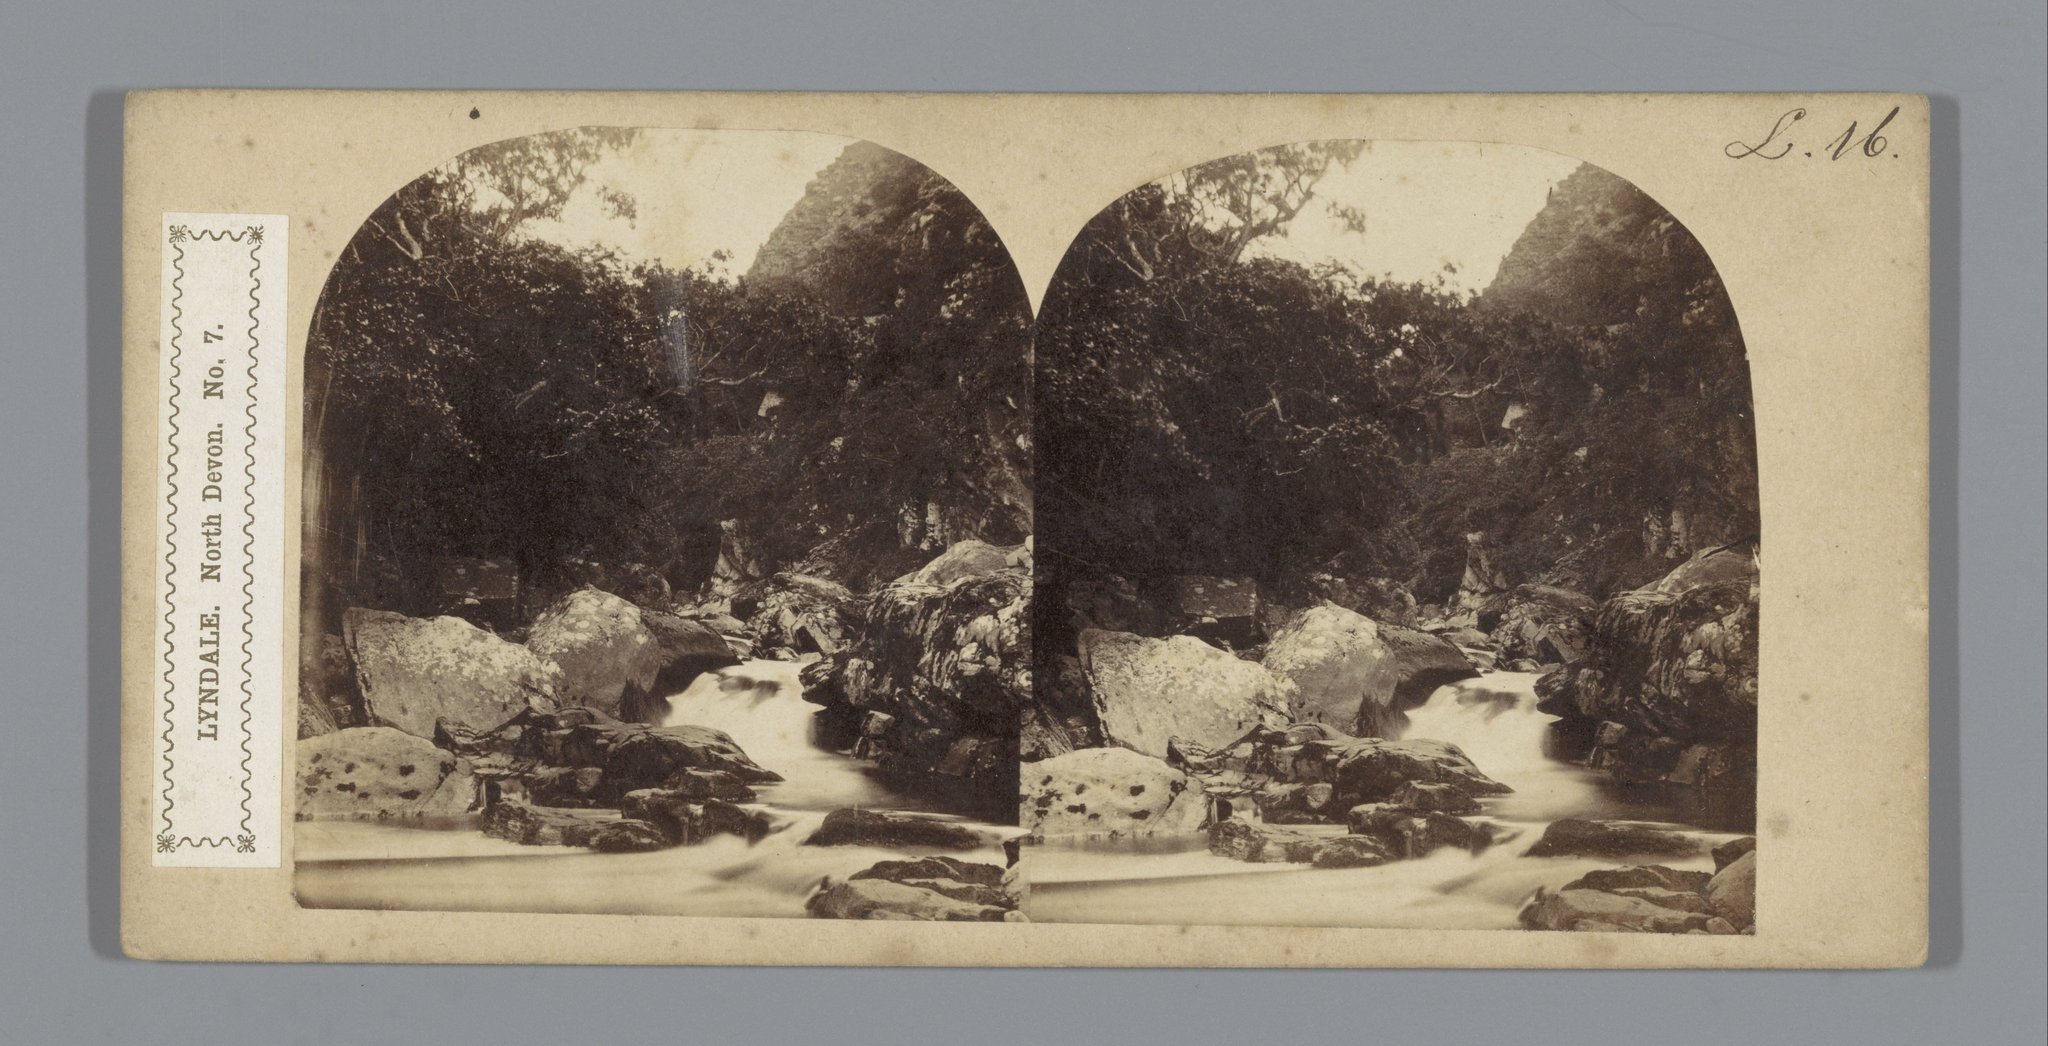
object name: stereograph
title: Gezicht op een rivier met rotsen bij Devon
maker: Anonymous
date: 1860-1865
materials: cardboard, photographic support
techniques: albumen print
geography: england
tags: river, rock-formations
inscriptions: number: ‘25’, number: ‘L. 16.’, number: ‘No. 7.’